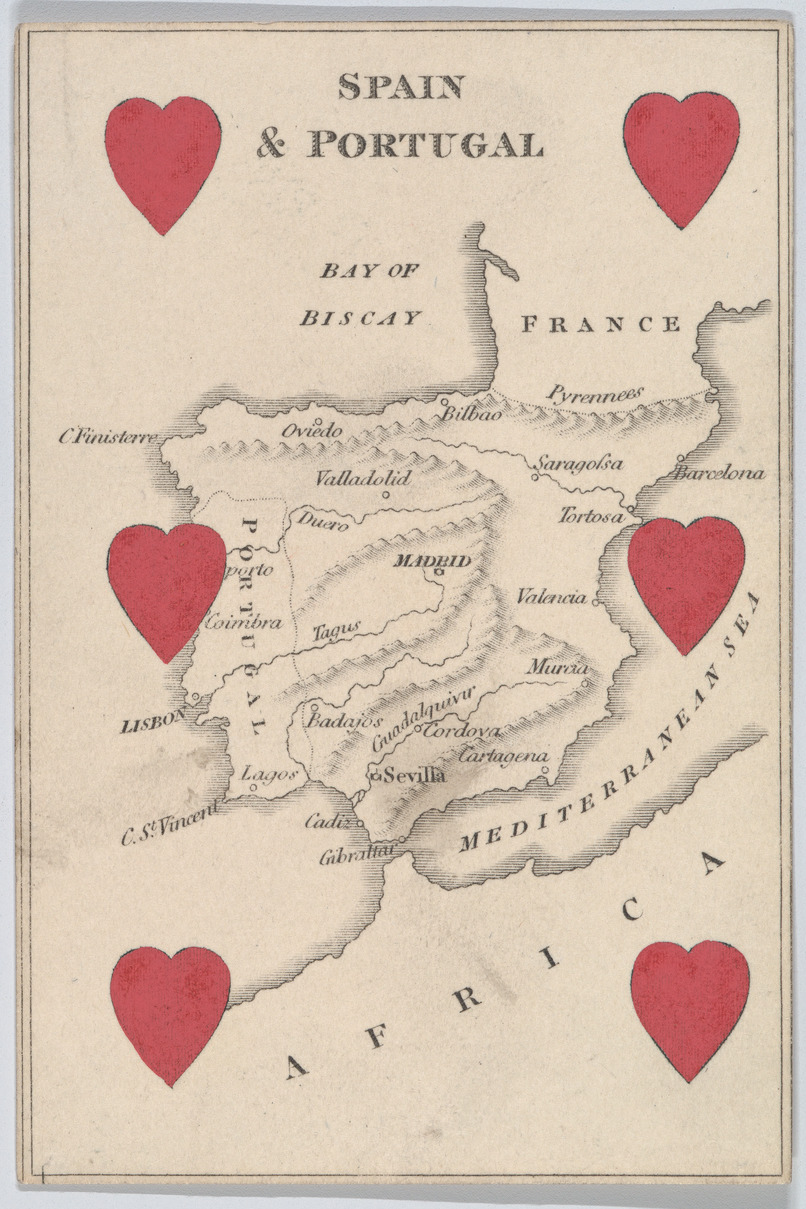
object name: print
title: Spain and Portugal in Europe, from "Court Game of Geography"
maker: william and henry rock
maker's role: publisher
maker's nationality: british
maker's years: 1821-1884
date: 1838-1855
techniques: engraving, hand coloring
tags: playing cards,maps